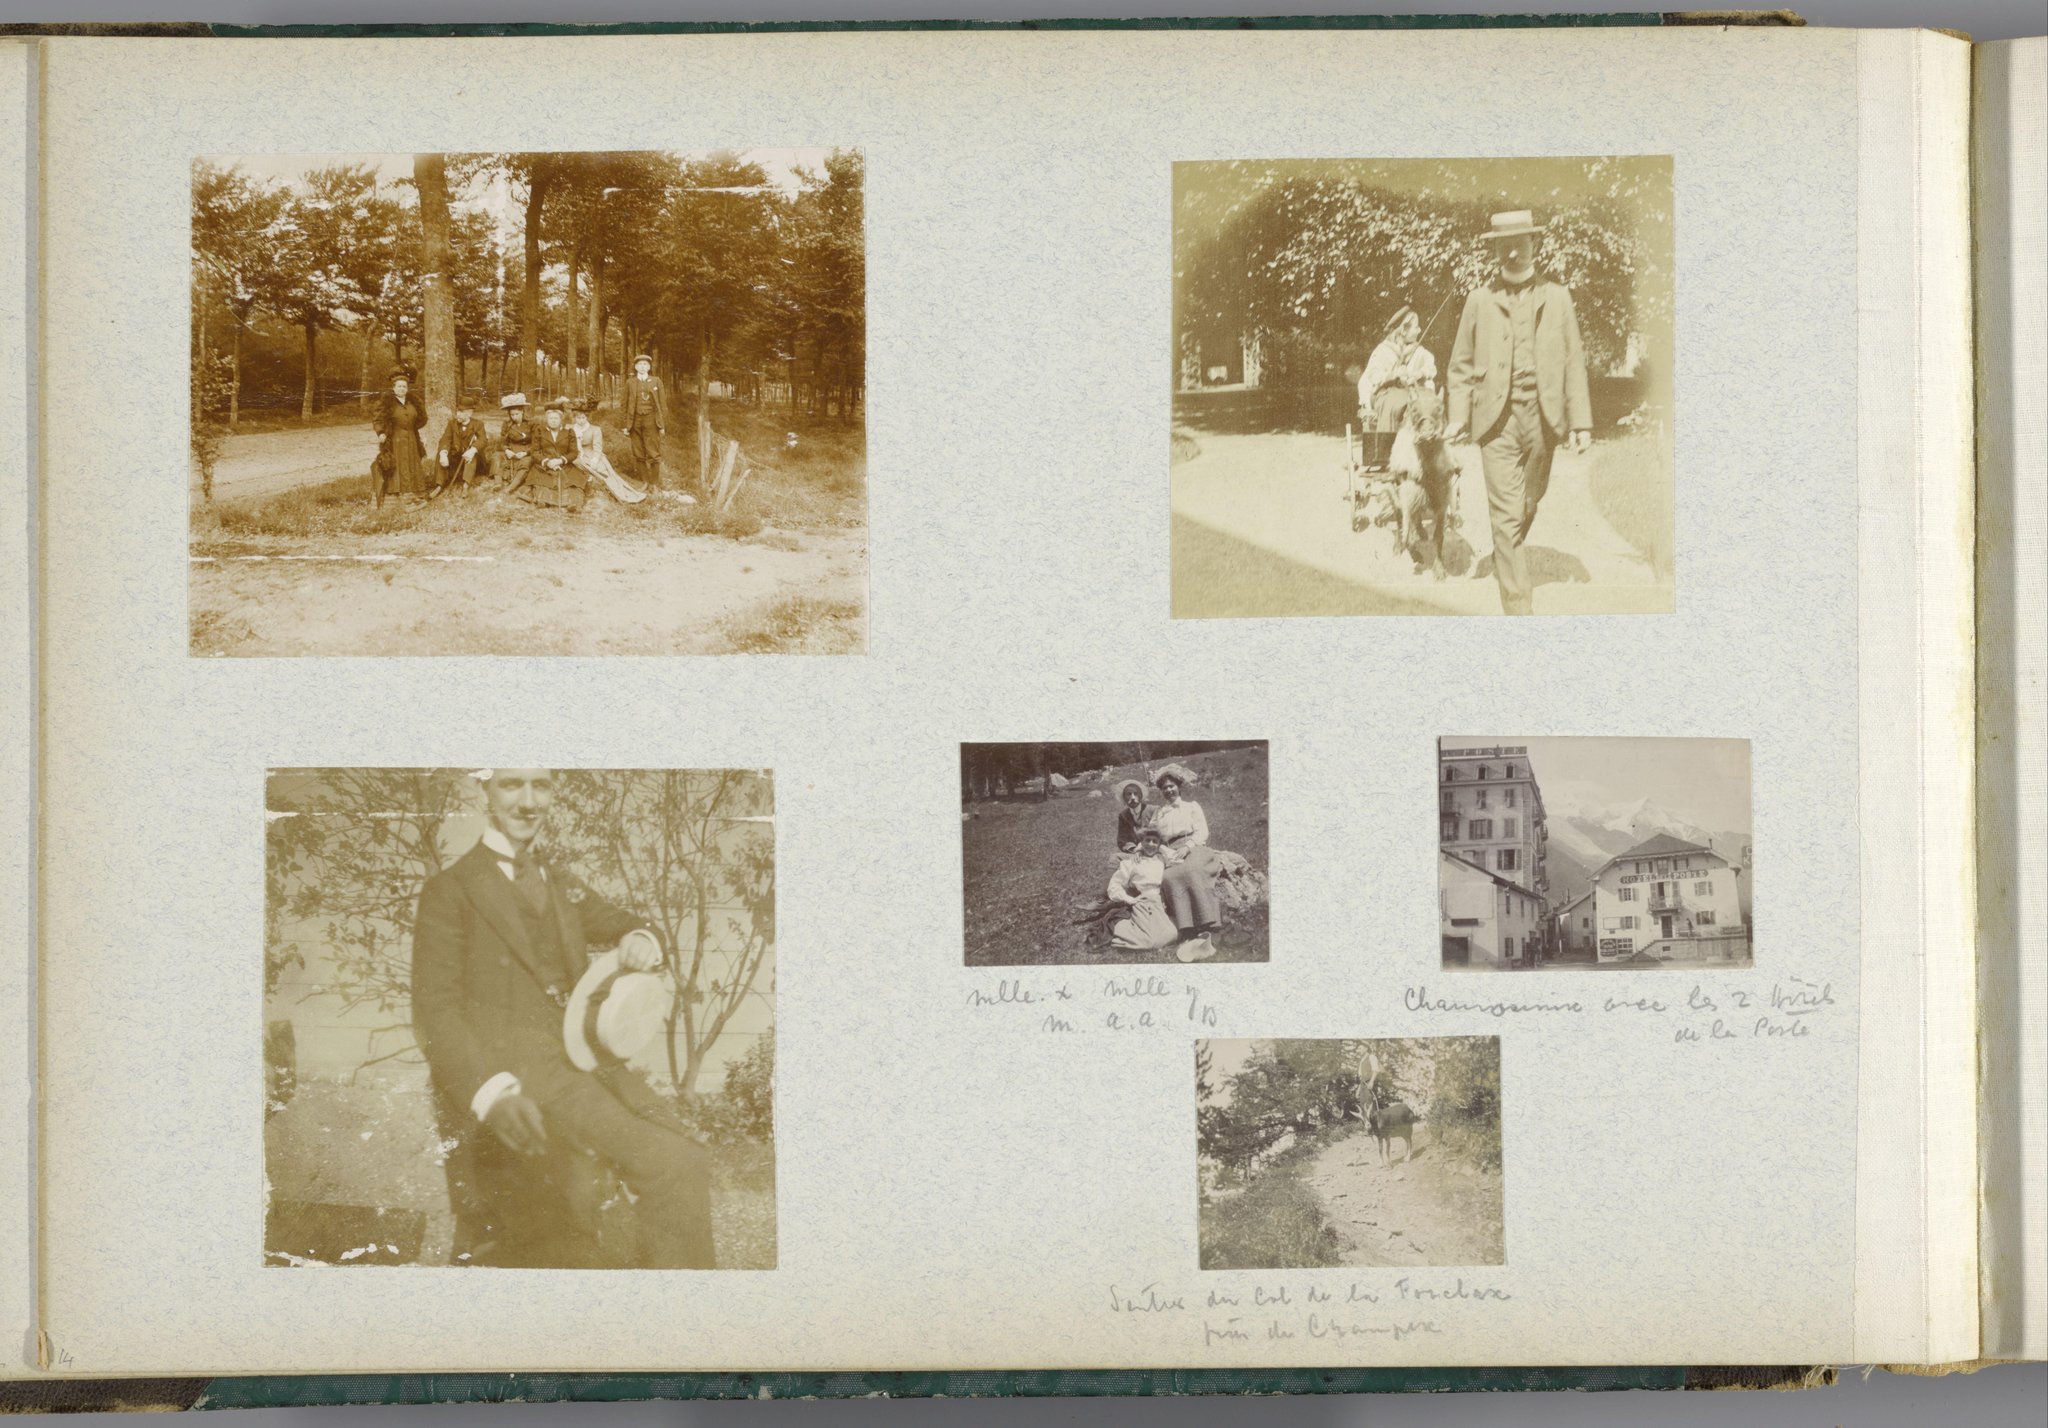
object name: album leaf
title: Albumblad met zes foto's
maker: andries augustus boom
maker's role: amateurfotograaf, handelaar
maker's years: 1878-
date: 1900-1910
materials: paper, photographic support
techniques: photography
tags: andries augustus boom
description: Albumblad met zes foto's. Onderdeel van het fotoalbum van de familie Boom-Gonggrijp in Suriname en Curaçao.